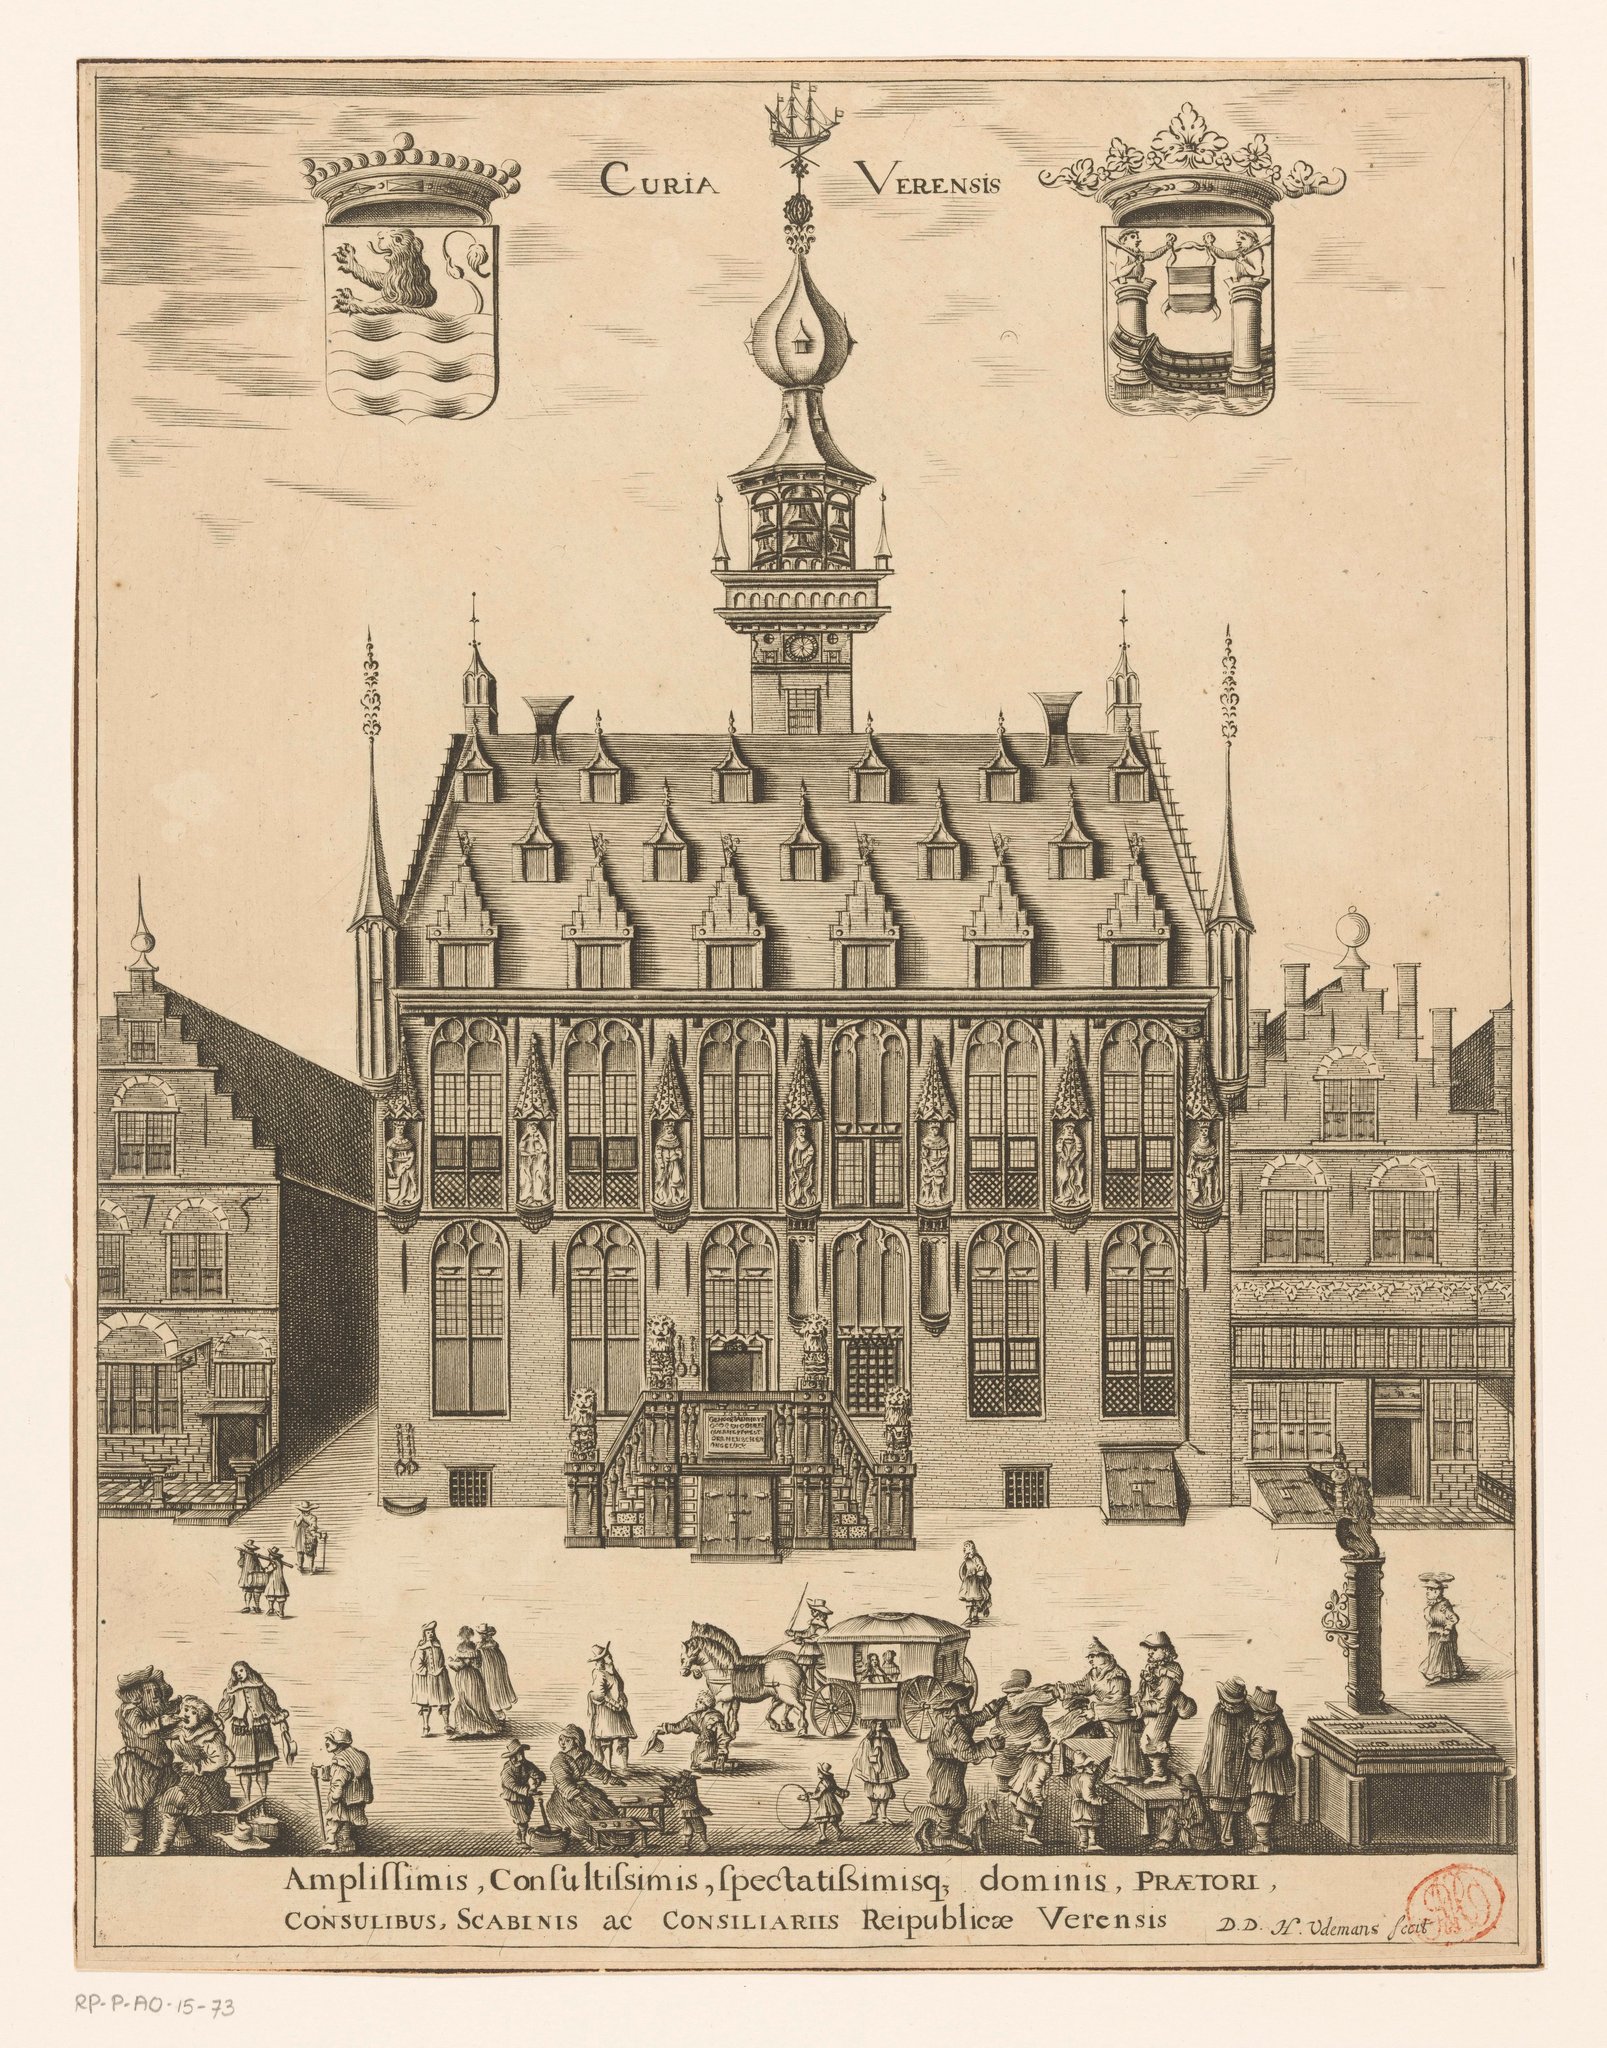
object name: print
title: Curia Verensis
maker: hendrik udemans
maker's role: print maker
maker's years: 1622-1659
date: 1647-1659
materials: paper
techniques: engraving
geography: zeeland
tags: coat of arms (as symbol of the state, etc.) (+ city; municipal), townhall, coat of arms (as symbol of the state, etc.) (+ province; provincial)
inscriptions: collector's mark: Lugt 2228, collector's mark: Lugt 195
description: Gezicht op het stadhuis van Veere. Linksboven het wapen van Zeeland, in het midden de titel en rechtsboven het wapen van Veere. Voor het stadhuis verschillende figuren en een koets. Onder de voorstelling de opdracht in twee regels in het Latijn.